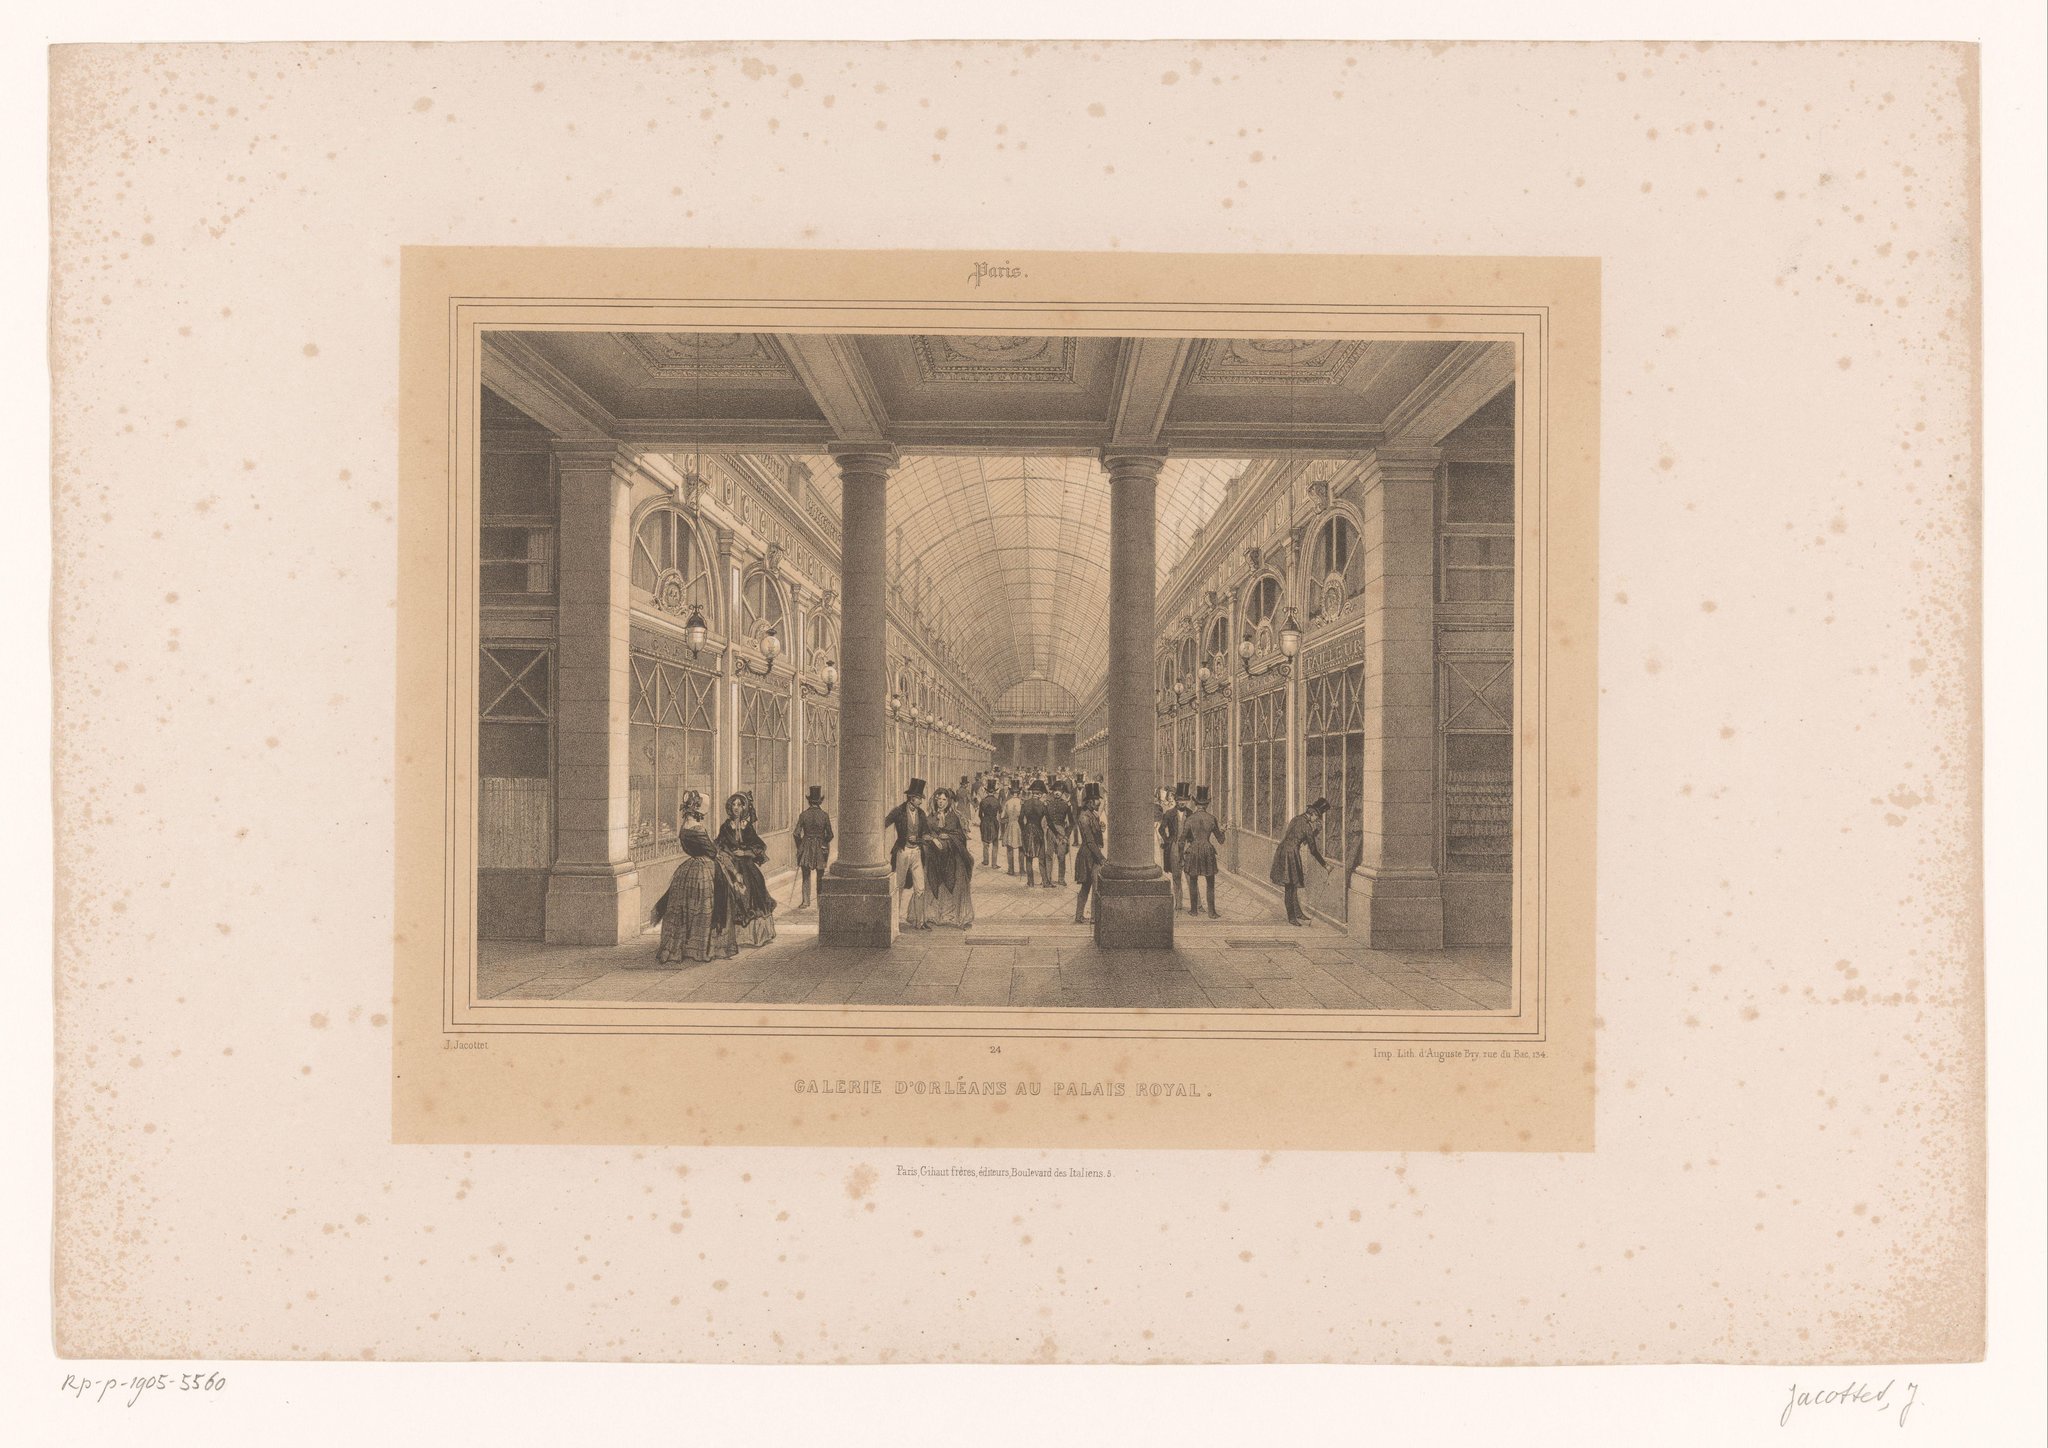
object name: print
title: Gezicht in de Galerie d'Orléans van het Palais-Royal in Parijs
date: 1838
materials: paper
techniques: tone lithography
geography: paris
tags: hôtel, i.e. small palace in city - aa - civic architecture: inside, gallery (spacious corridor)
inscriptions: collector's mark: Lugt 2228a